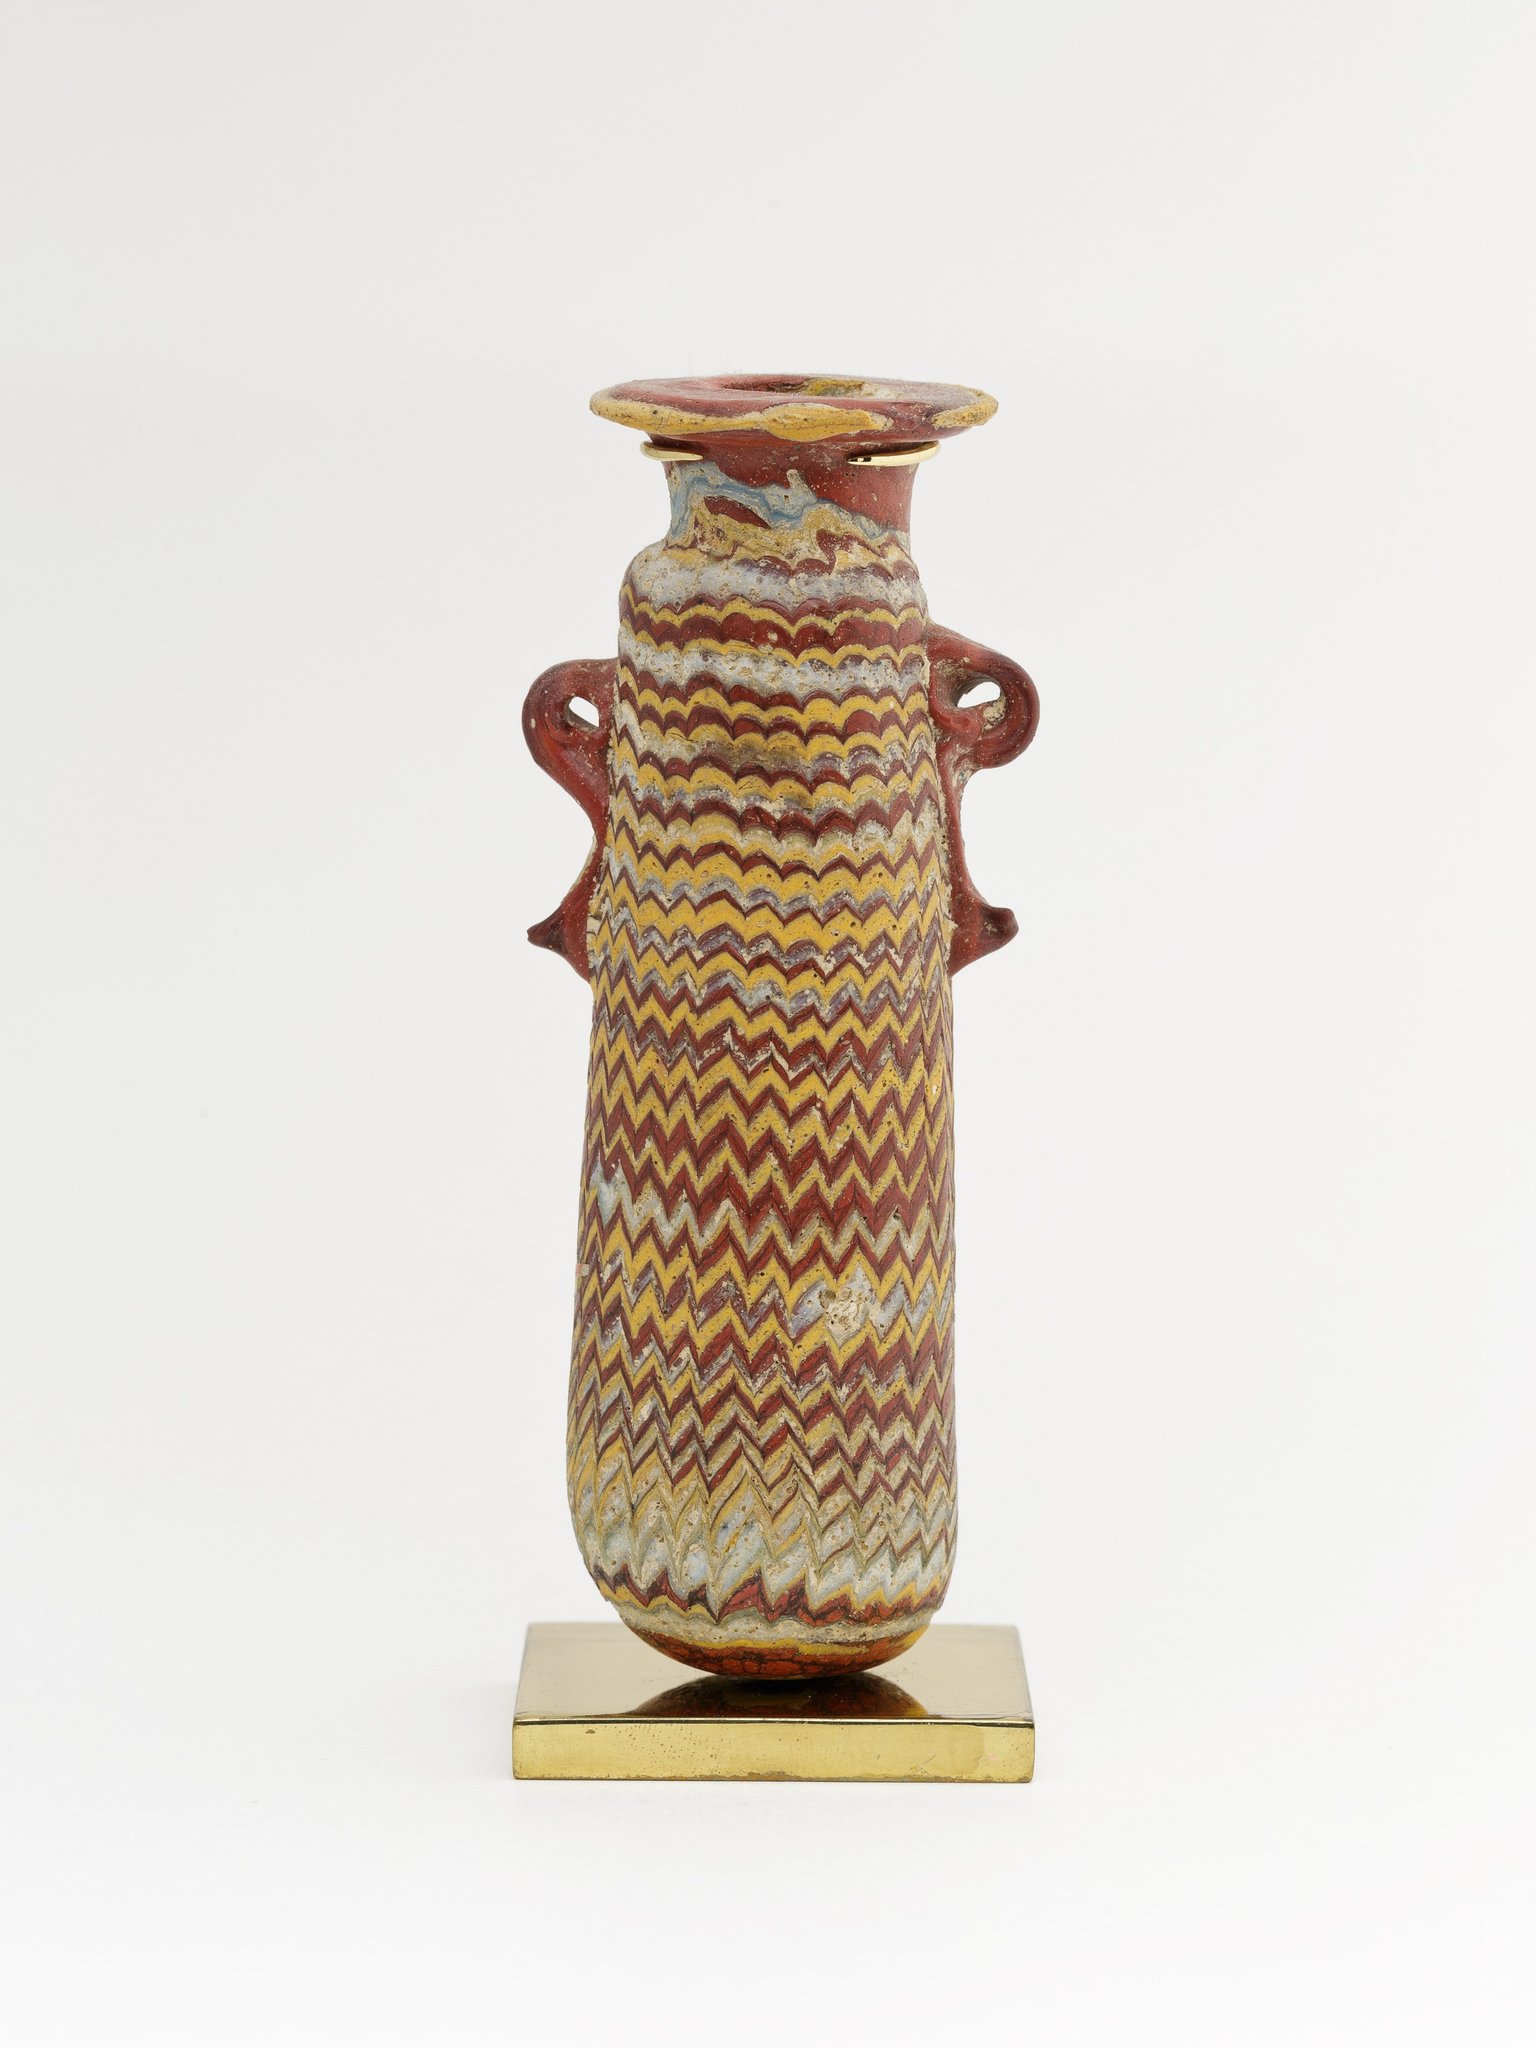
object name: vessel, unguent, alabastron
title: Unguent vessel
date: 664-380 BCE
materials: glass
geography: egypt